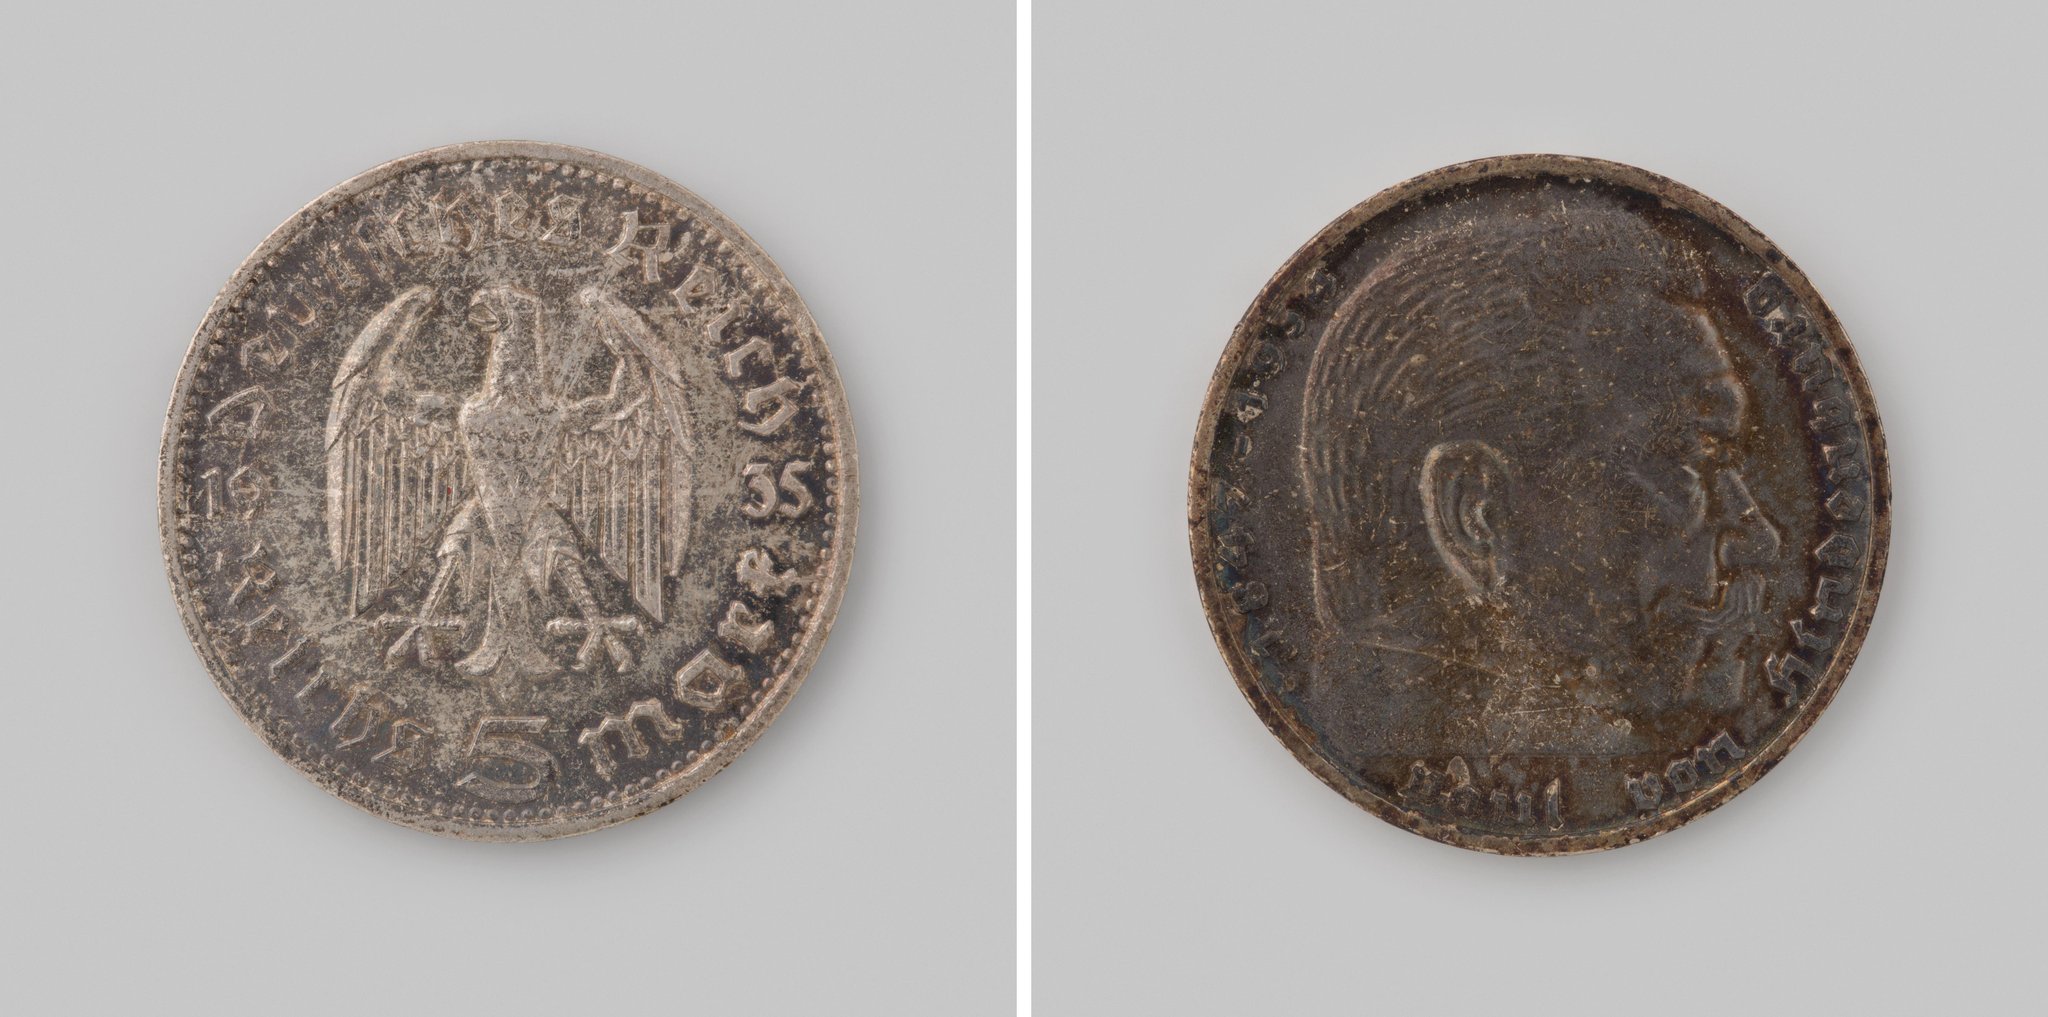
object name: coin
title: Duitsland, 5 reichs mark, 1935 D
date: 1935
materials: silver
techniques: striking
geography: munich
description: Zilveren herdenkingsmuntmunt. Voorzijde: tussen jaartal enkelkoppige adelaar naar links. Waarde-aanduiding in het omschrift. Keerzijde: portret van Paul von Hindenburg naar rechts. Als omschrift naam en jaartallen 1847-1934. Links van hals letter D [=München]. Randschrift.